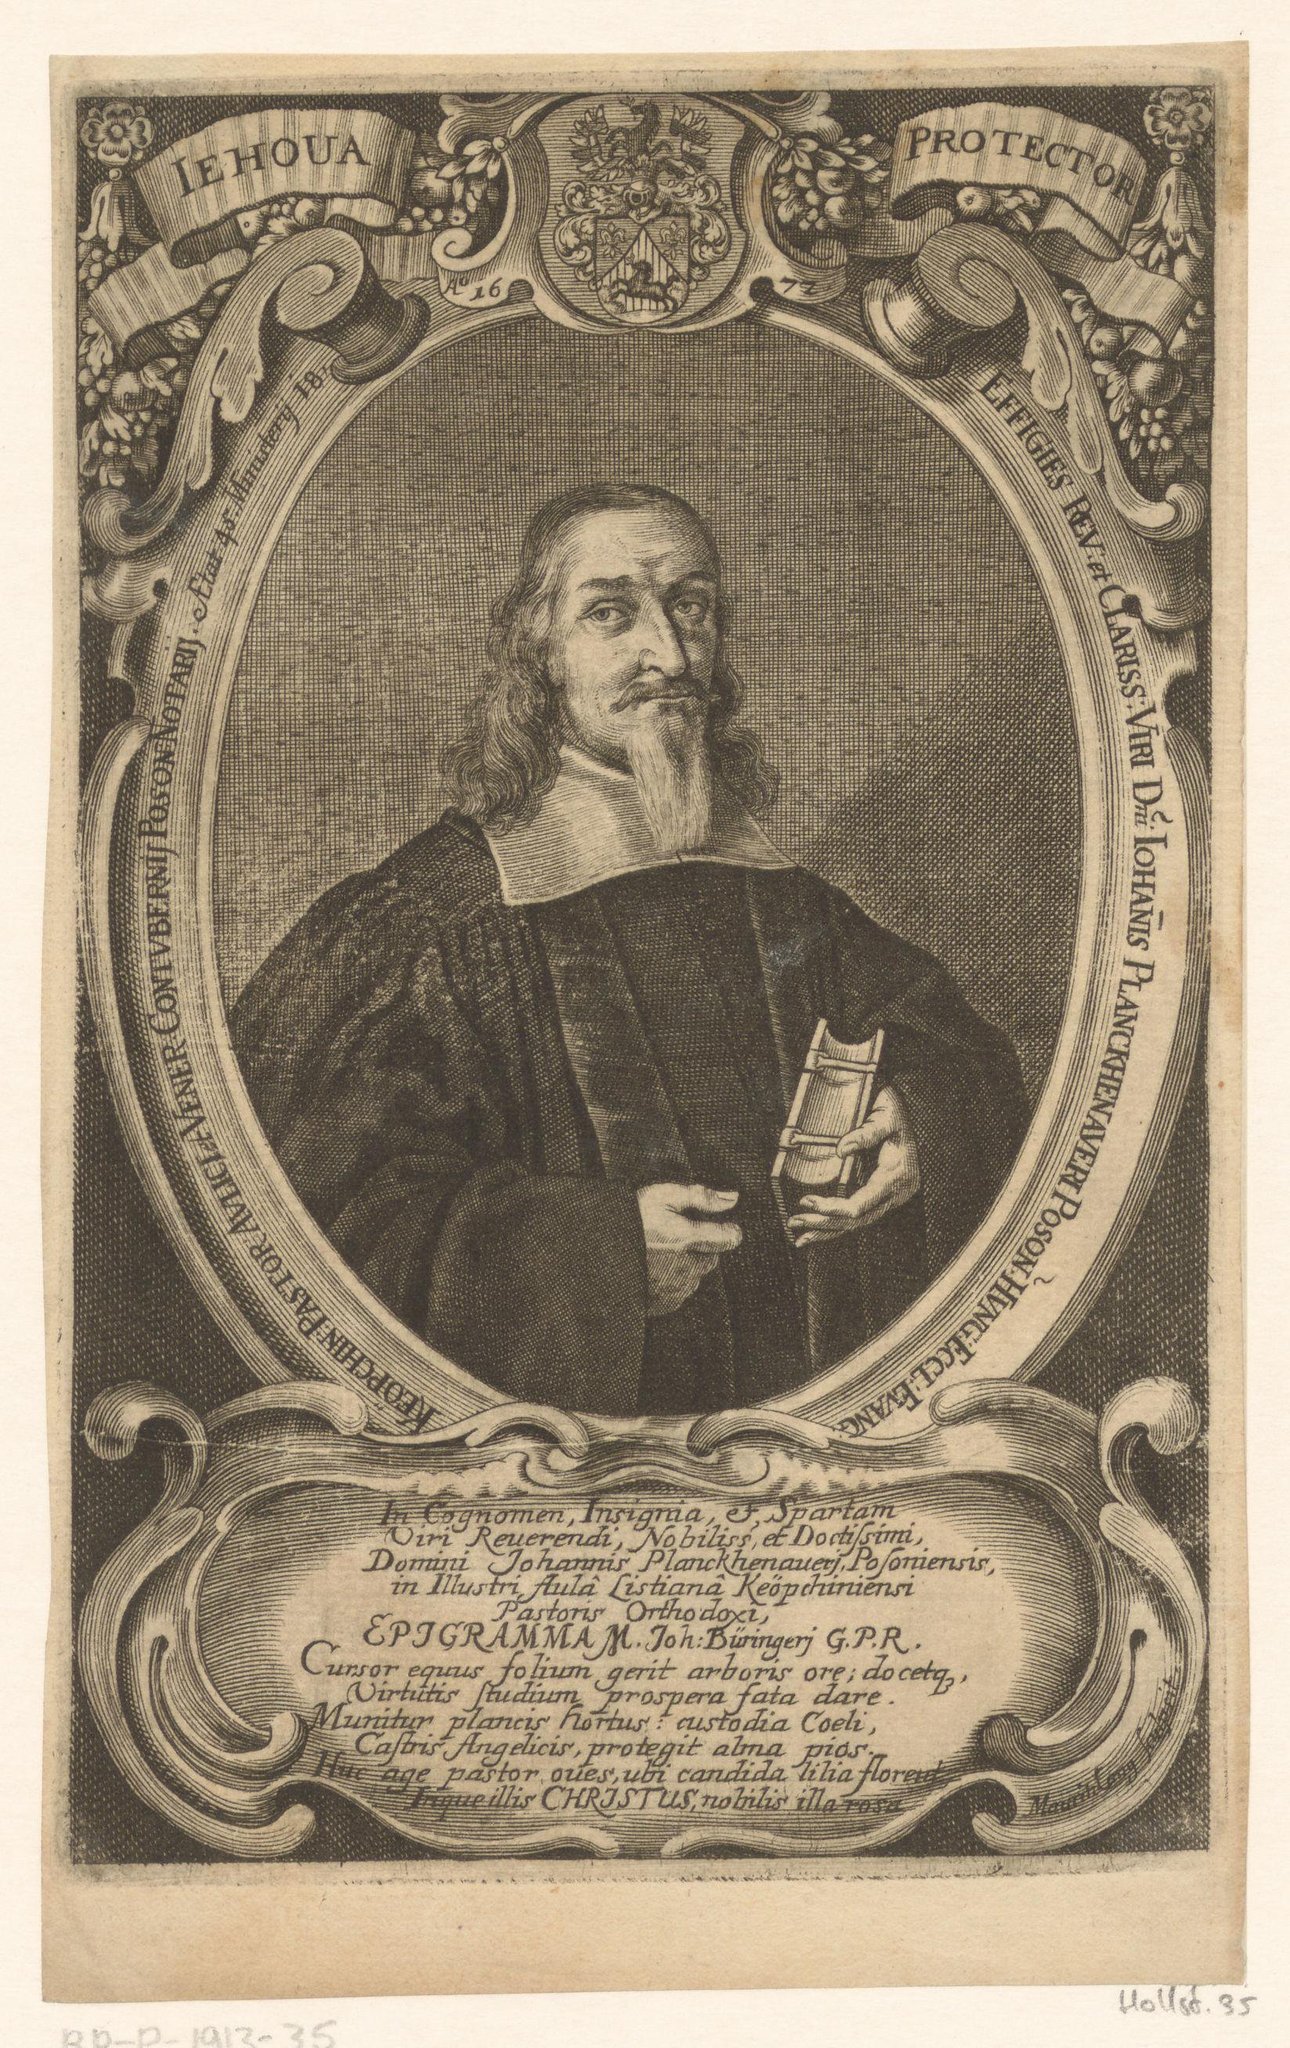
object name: print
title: Portret van Johann Planckenauer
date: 1672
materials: paper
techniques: engraving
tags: theologian, historical persons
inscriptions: collector's mark: Lugt 2228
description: Tekst in het Latijn in de omlijsting en in de cartouche.